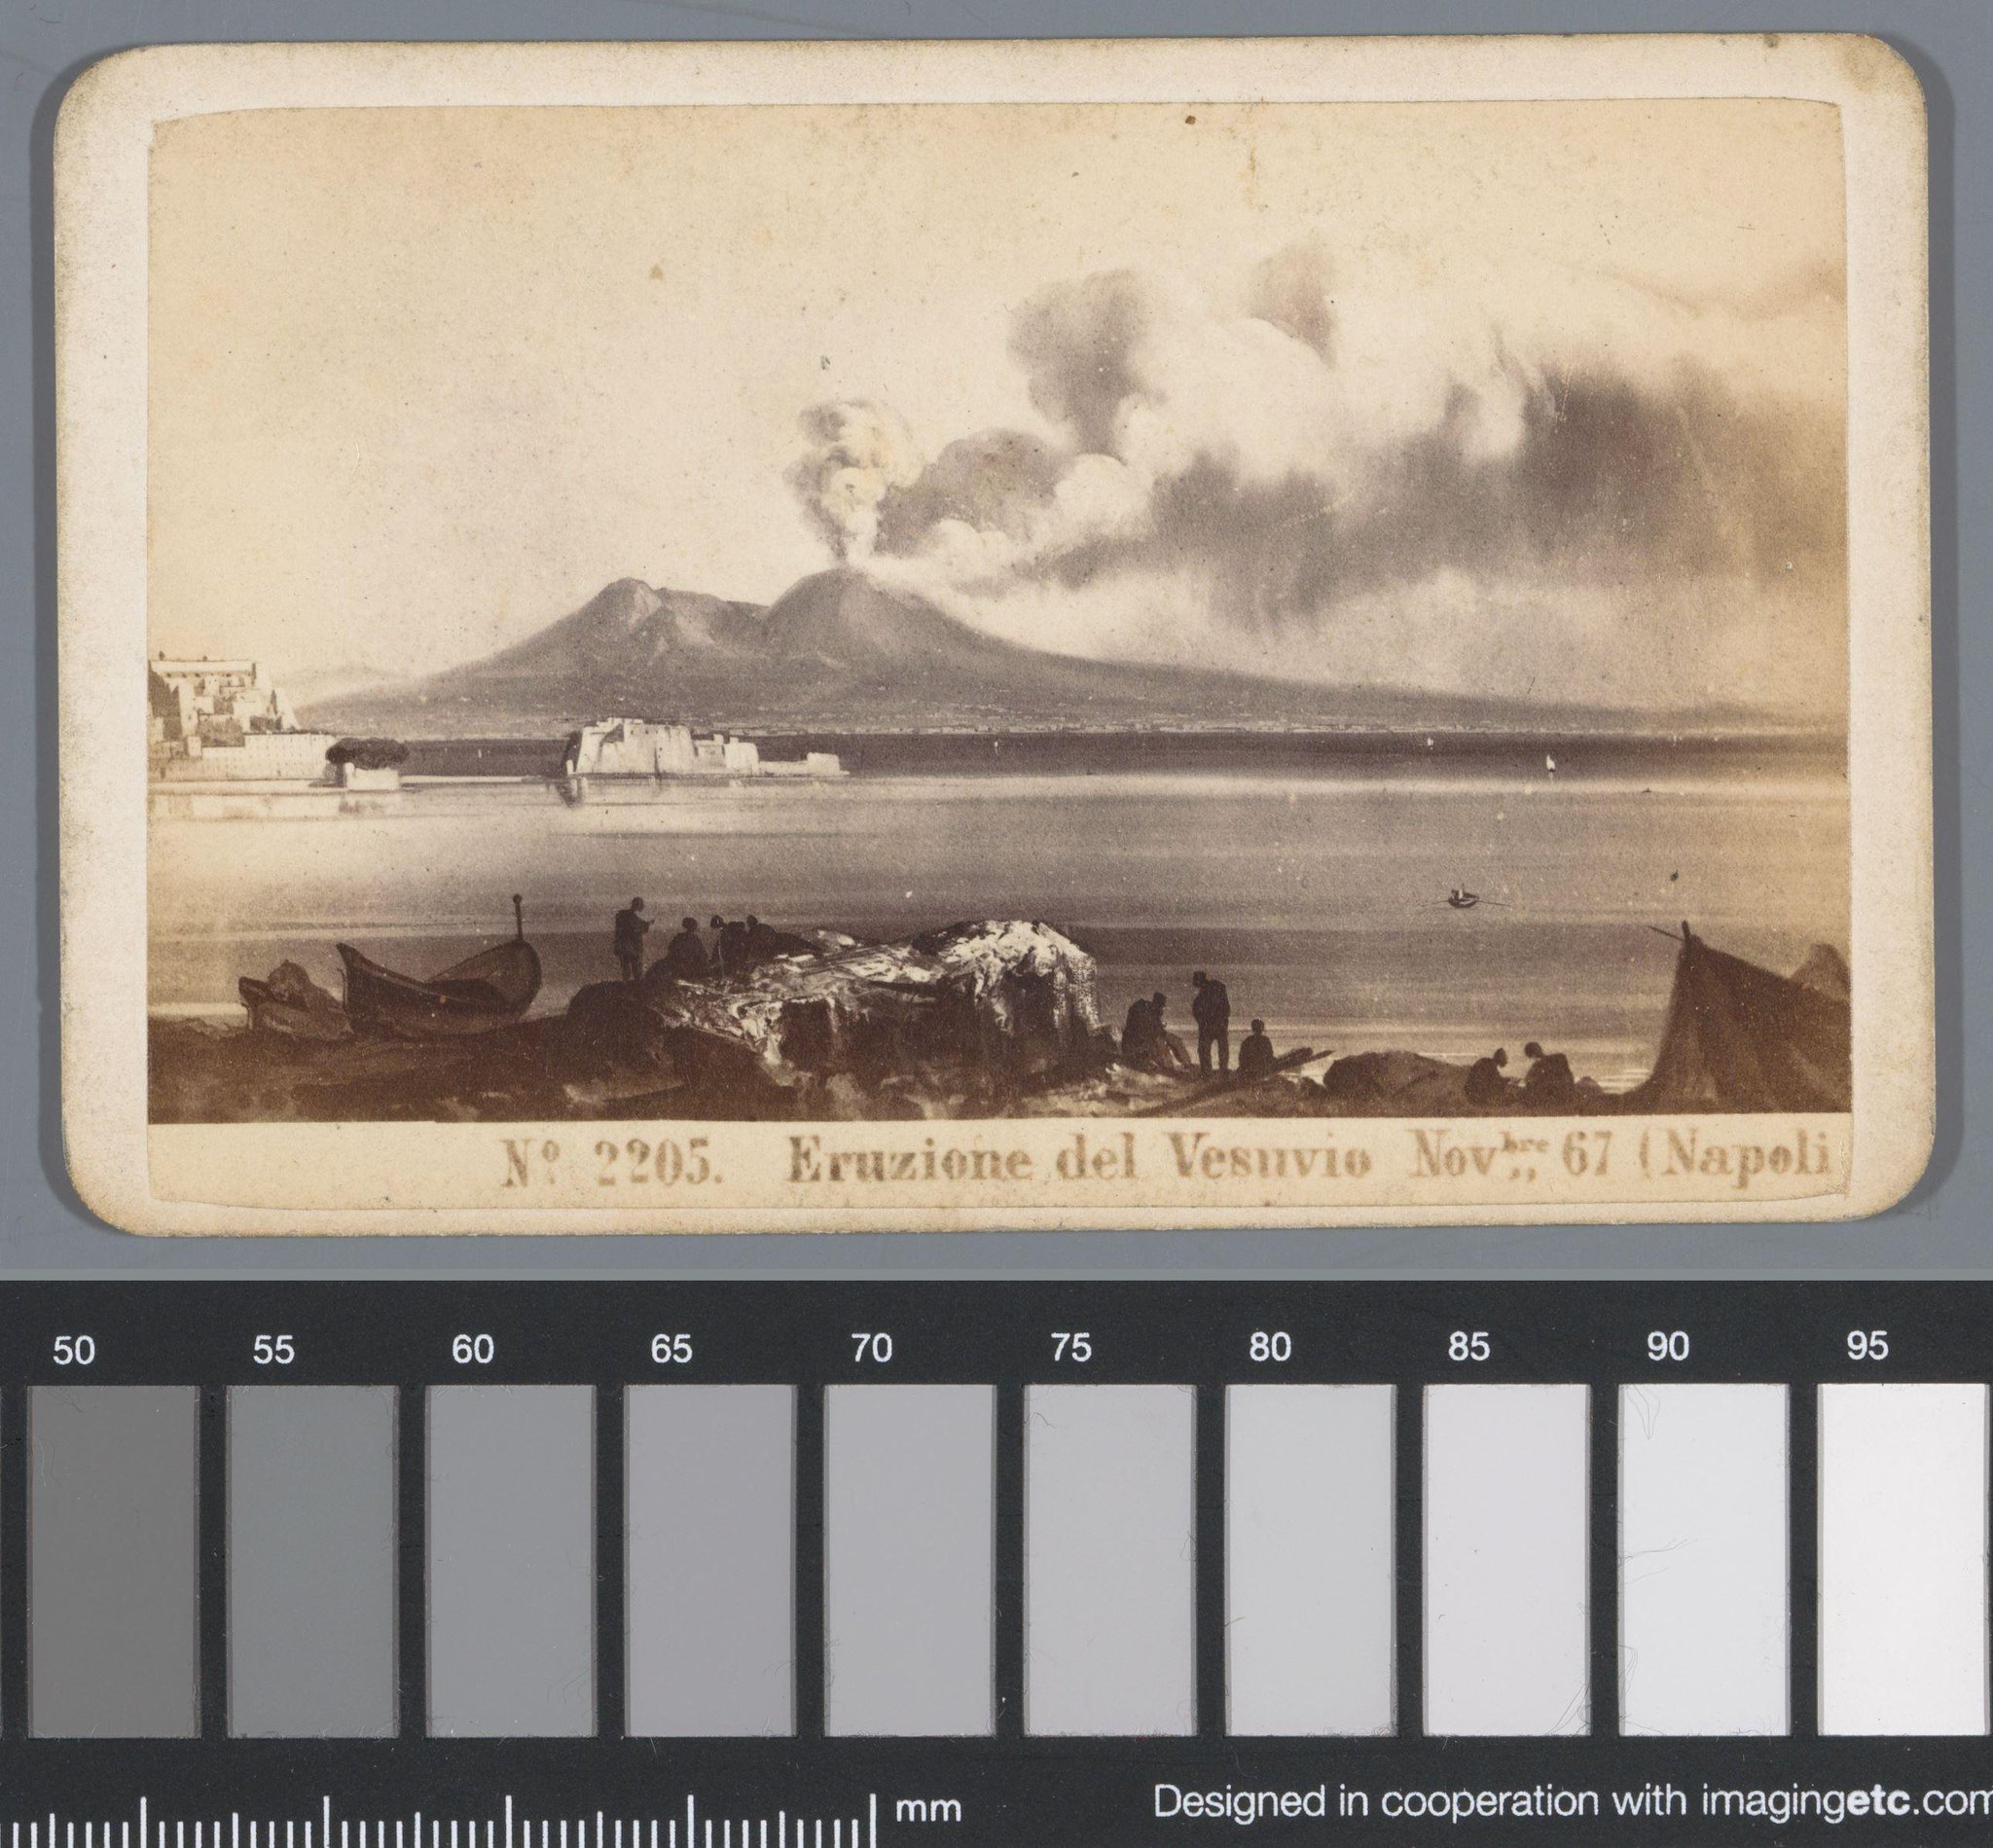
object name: photograph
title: Fotoreproductie van schilderij van een uitbarsting van de Vesuvius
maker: Anonymous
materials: cardboard, paper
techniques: albumen print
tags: eruption (of volcano), mount vesuvius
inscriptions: number: ‘No 2205.’